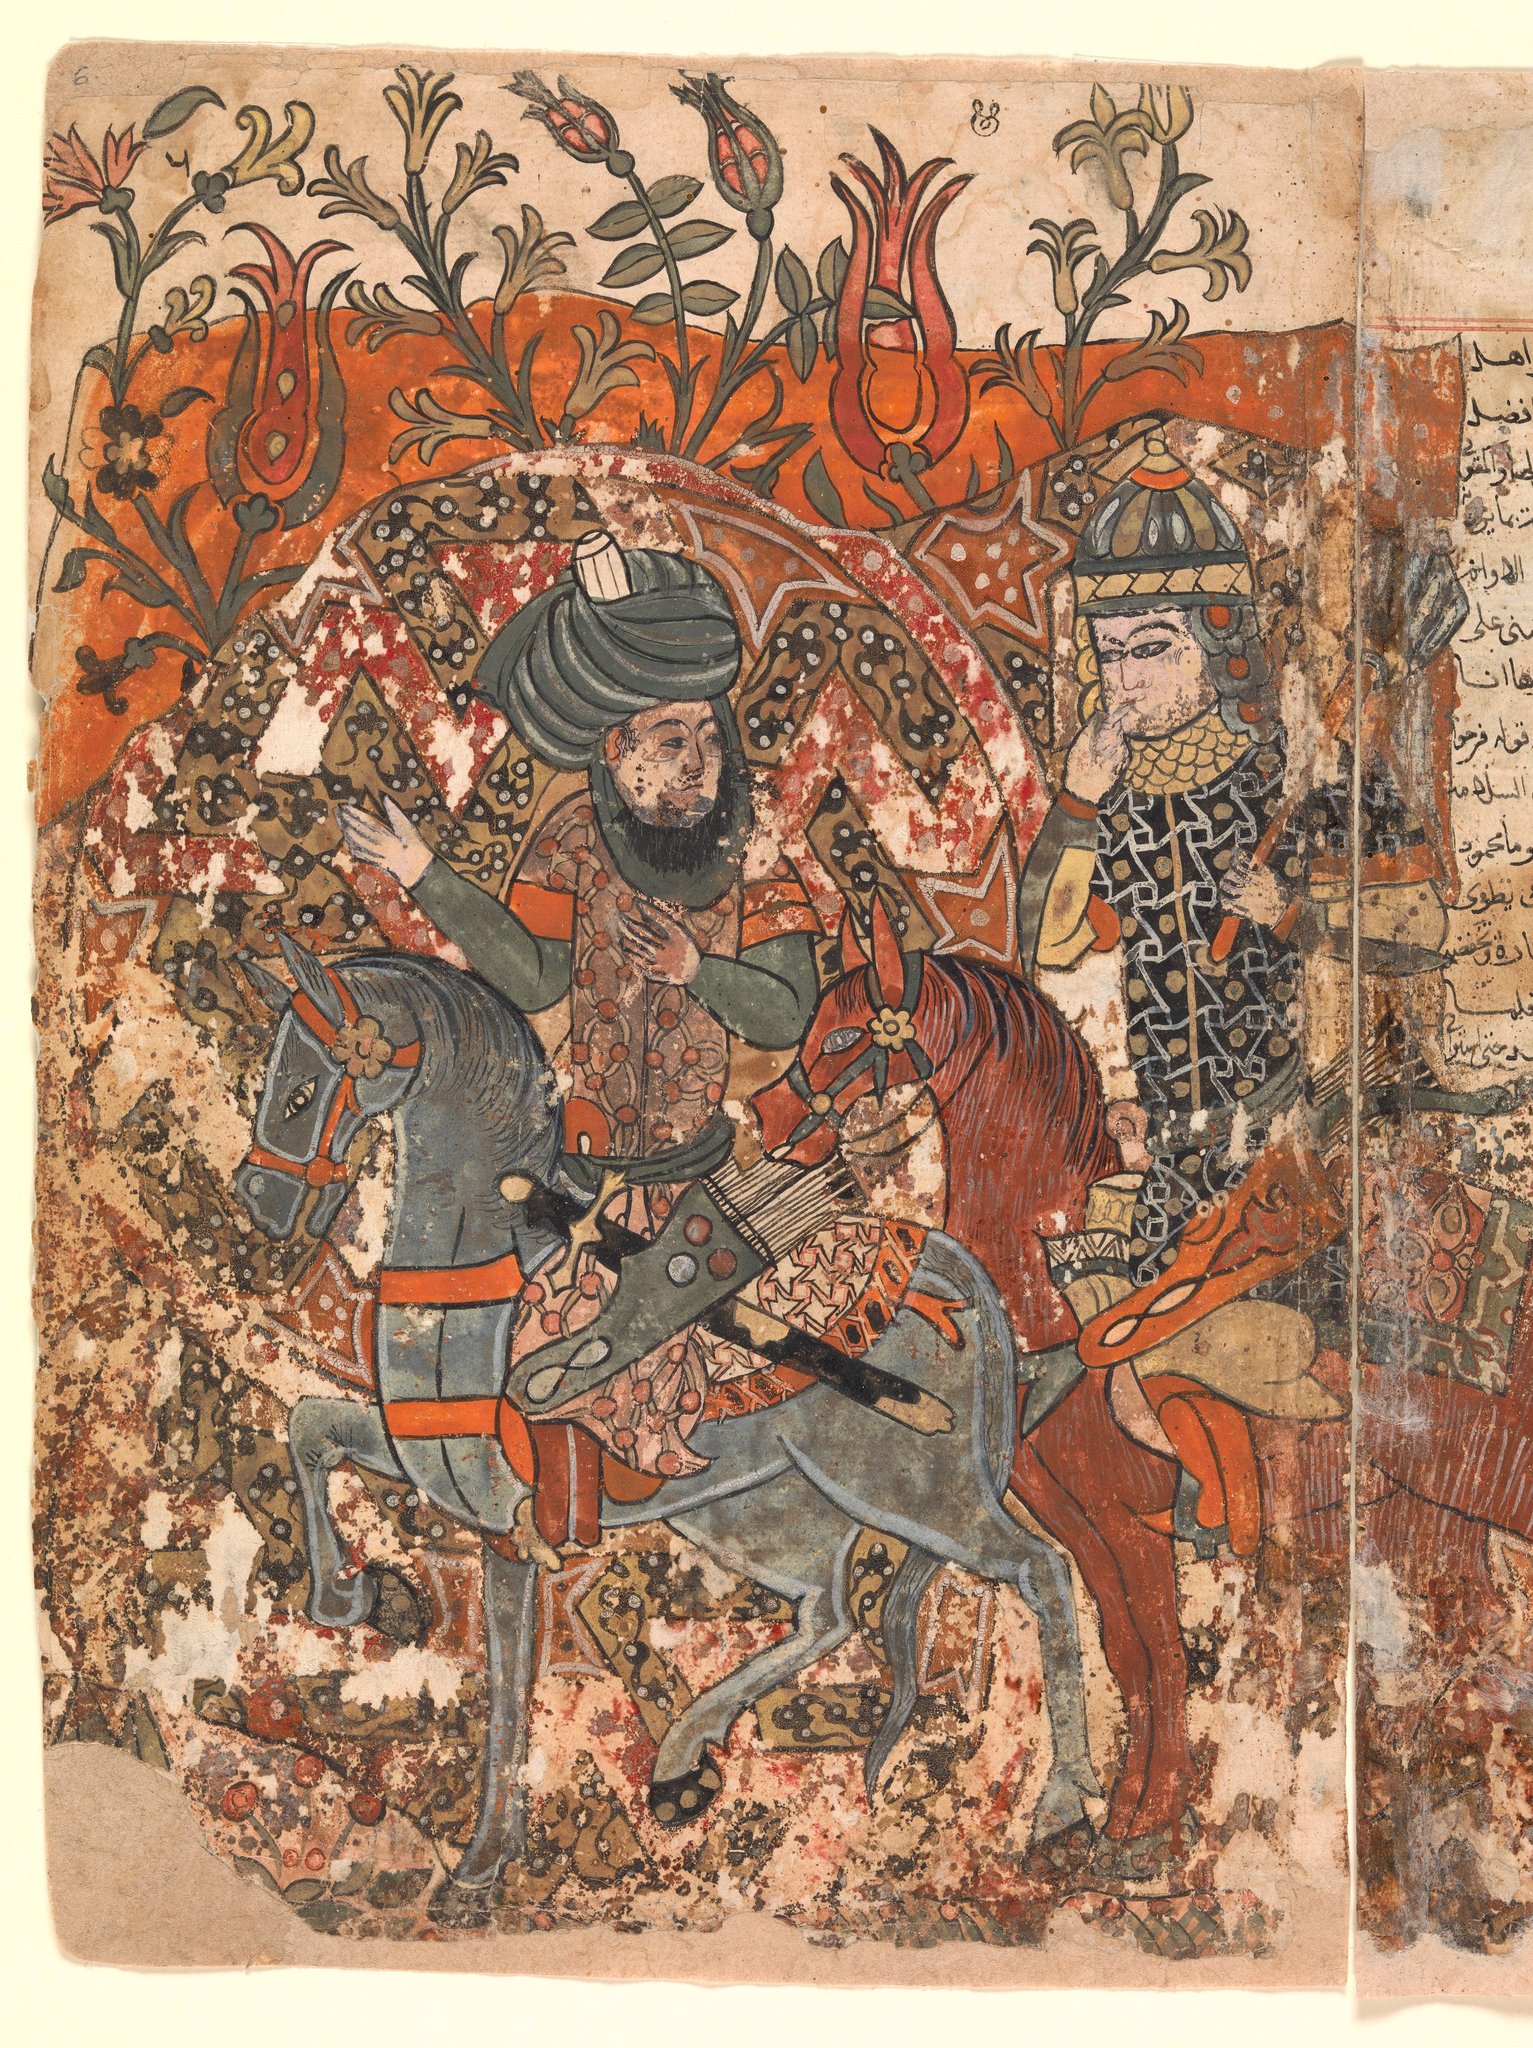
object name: folio from an illustrated manuscript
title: "Burzuya's Mission" Folio 5v, 6r from a Kalila Wa Dimna of Bidpai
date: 1526-1550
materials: ink, paper, watercolor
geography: india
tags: weapons,men,horses